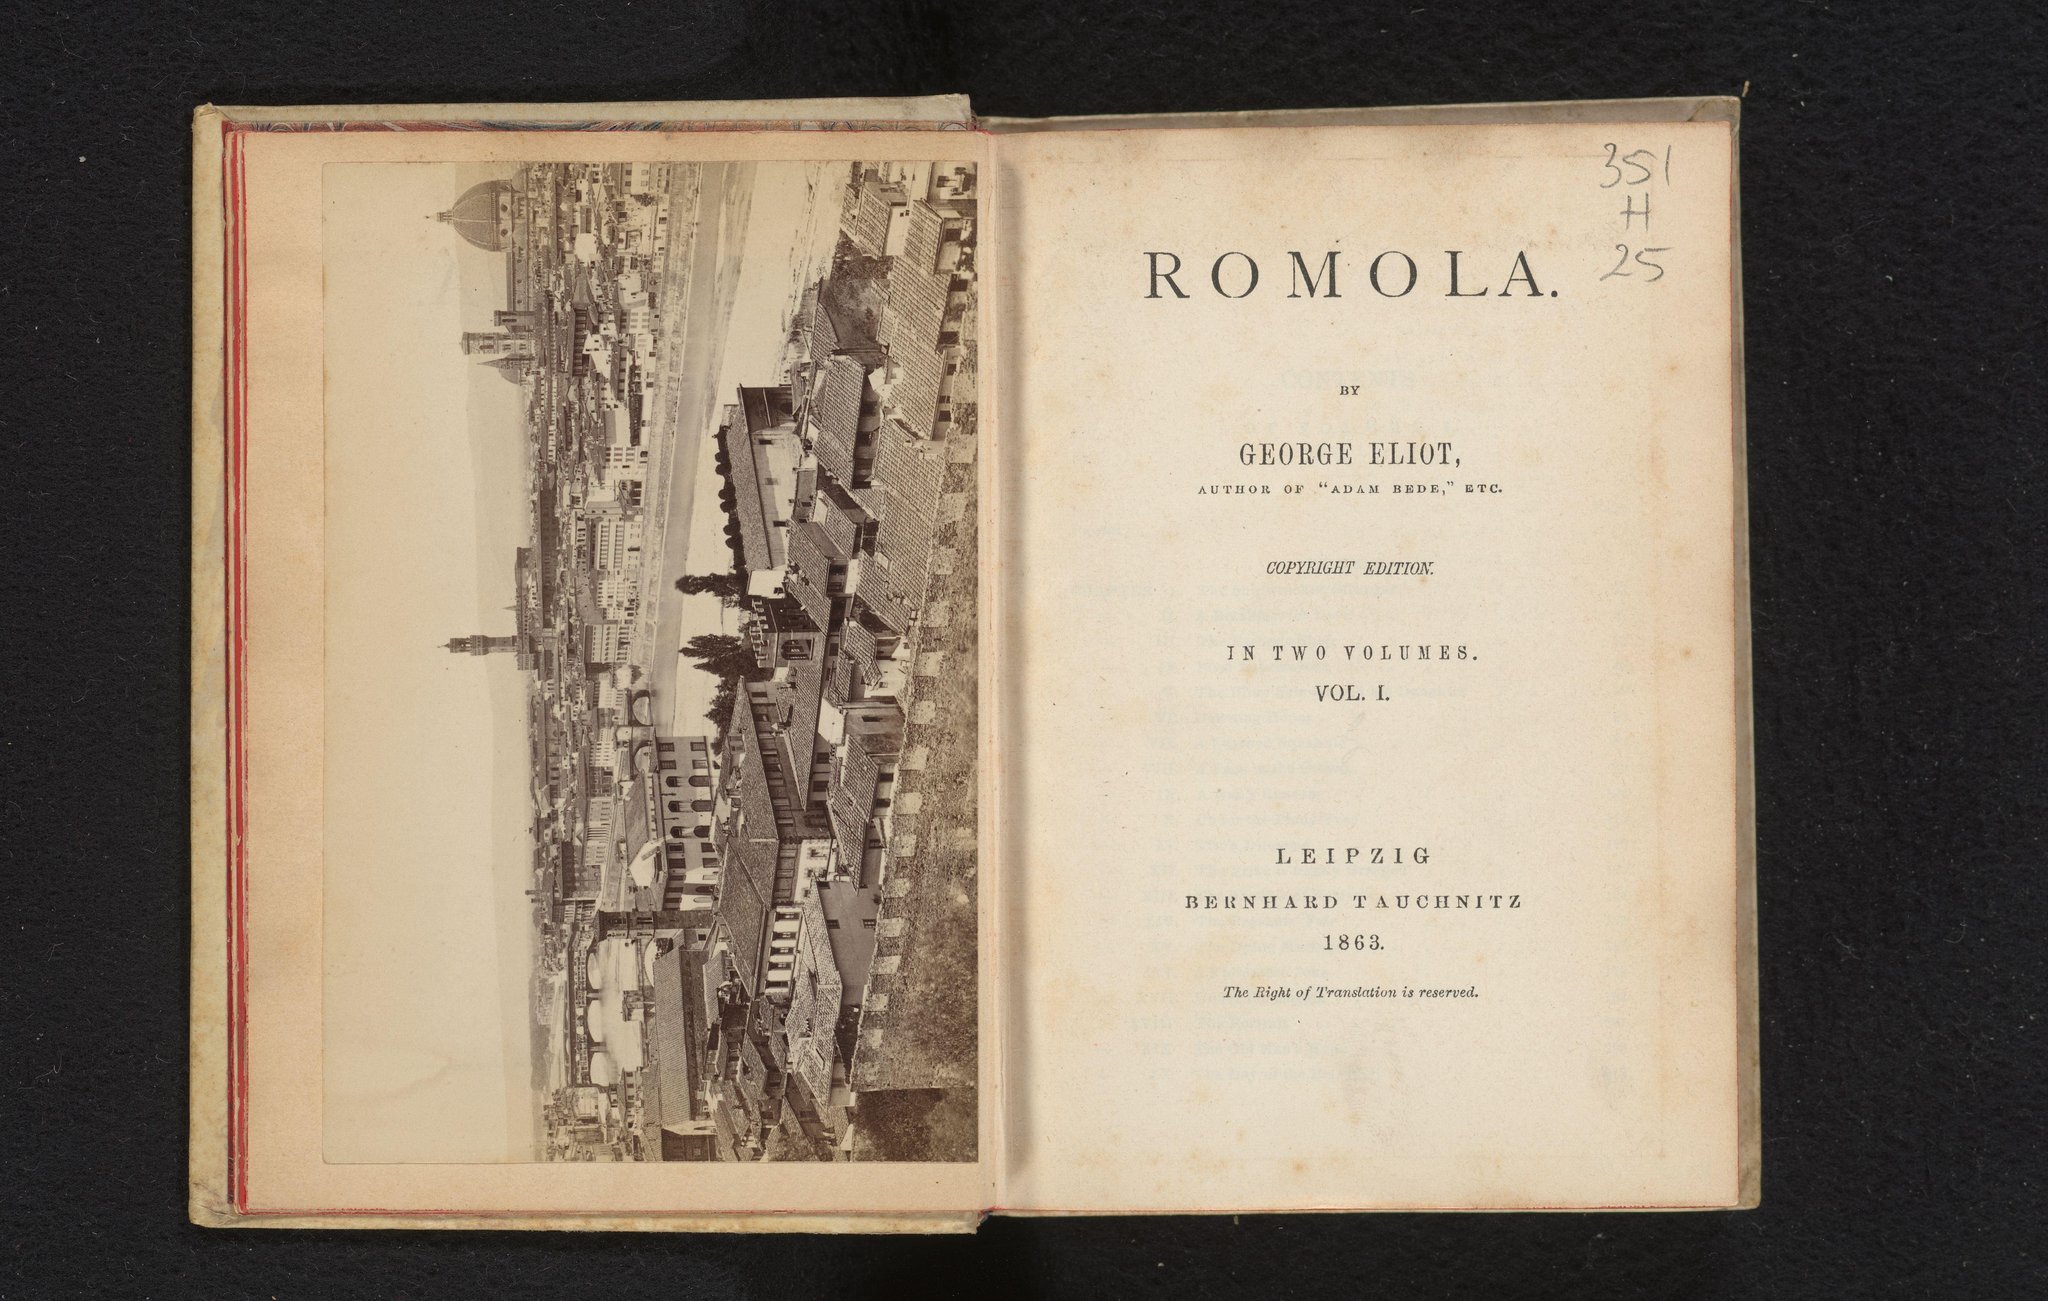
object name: book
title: Romola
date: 1863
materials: cardboard, paper, parchment, textile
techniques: albumen print, letterpress printing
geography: leipzig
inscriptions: retailer's mark: ‘Edward Goodban’, bookplate: ‘Pax et spes/ I.A. Pease’, inscription: ‘4800-/ 2 vol/ 43 albumines dont 19 reproductions/ dans le vol. I/ 29 albumines dont 9 reproductions/ dans le vol II/ 72 photos’